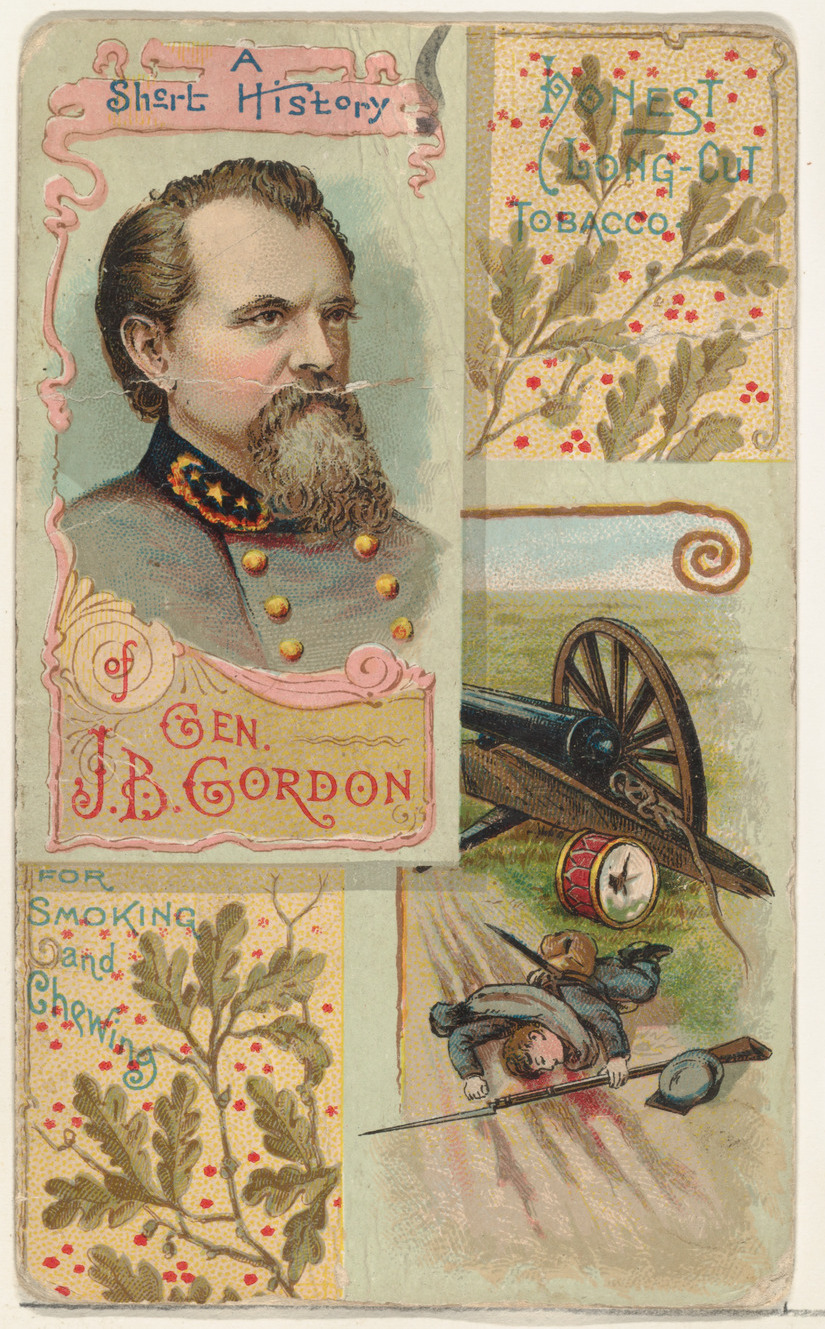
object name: print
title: A Short History: General John Brown Gordon, from the Histories of Generals series (N114) issued by W. Duke, Sons & Co. to promote Honest Long Cut Smoking and Chewing Tobacco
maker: w. duke, sons & co.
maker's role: publisher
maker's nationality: american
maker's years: 1870-1920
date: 1888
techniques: color lithograph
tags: men,portraits,generals